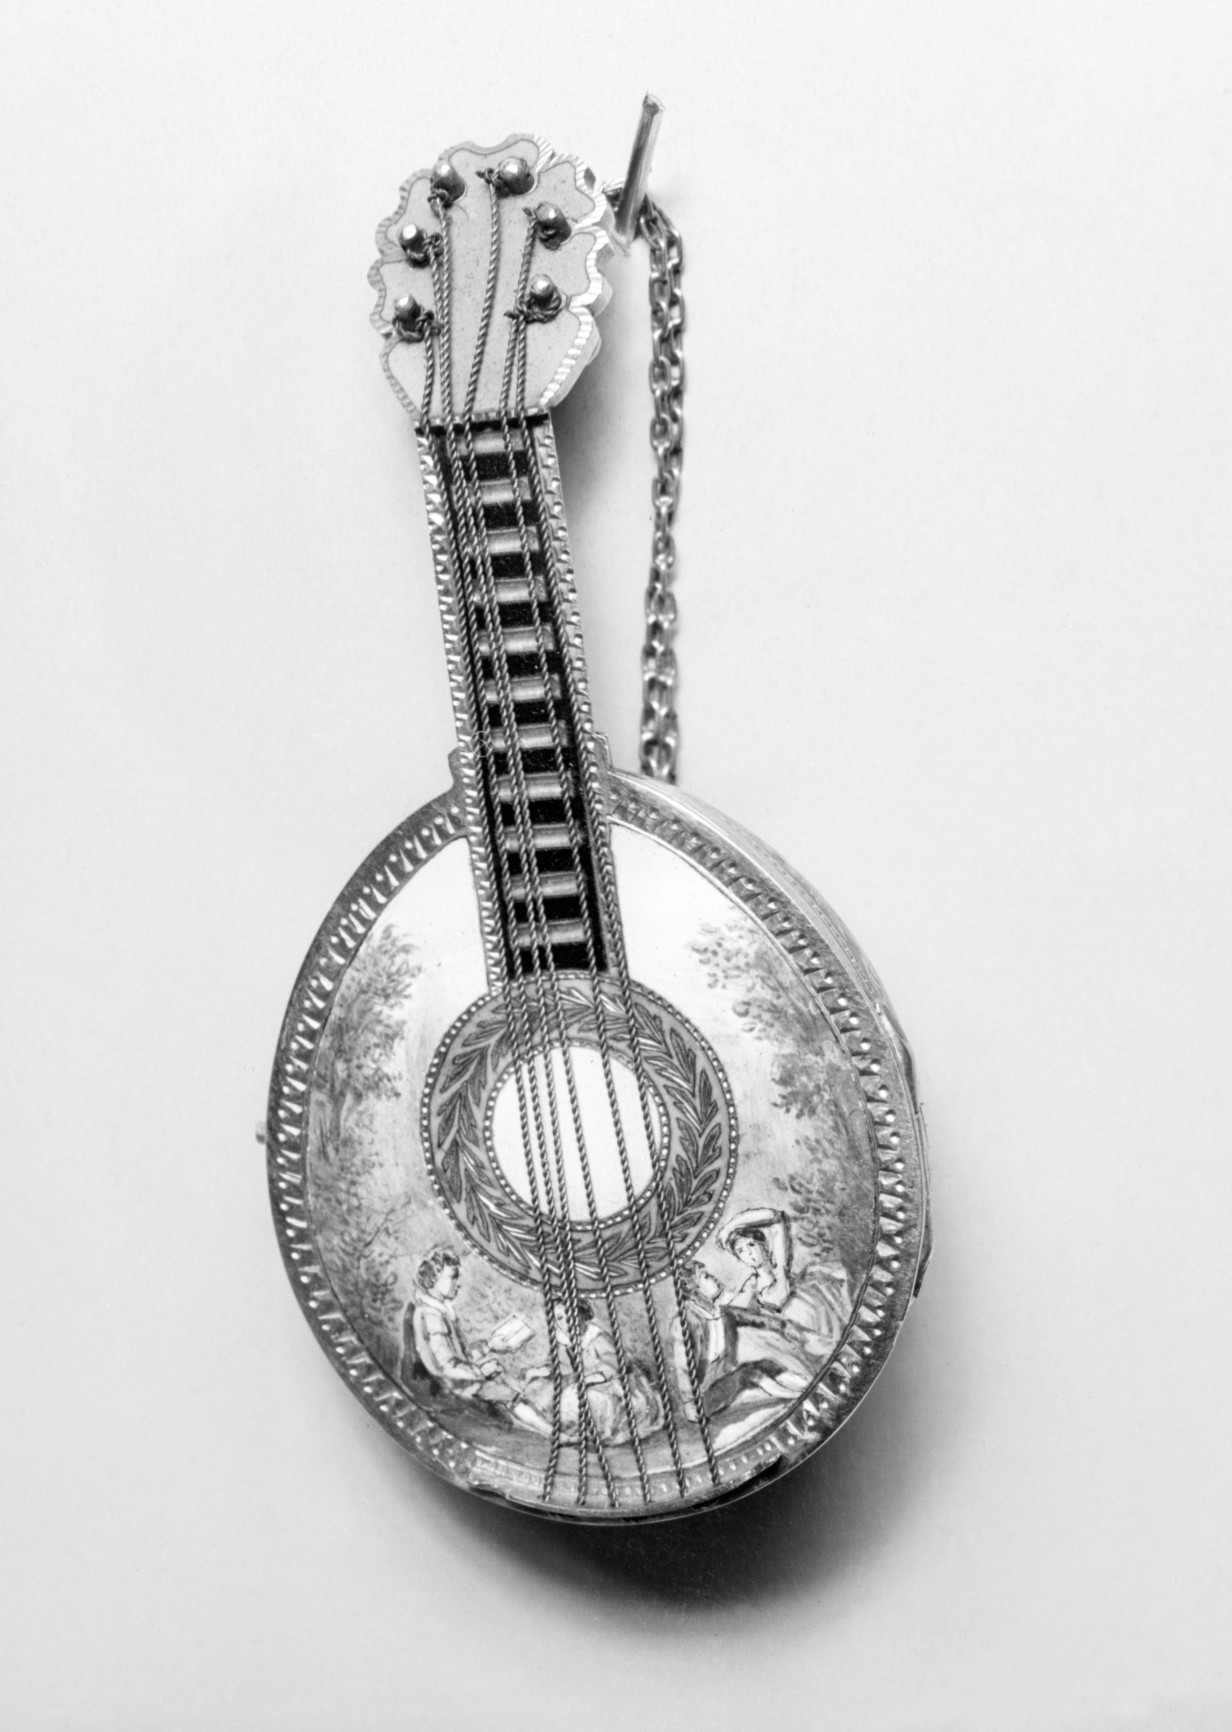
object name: watch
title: Watch in the shape of a mandolin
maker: jean-françois bautte & co.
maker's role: maker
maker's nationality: swiss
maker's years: 1837-1855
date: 1801-1833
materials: enamel, gold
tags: men,women,mandolins